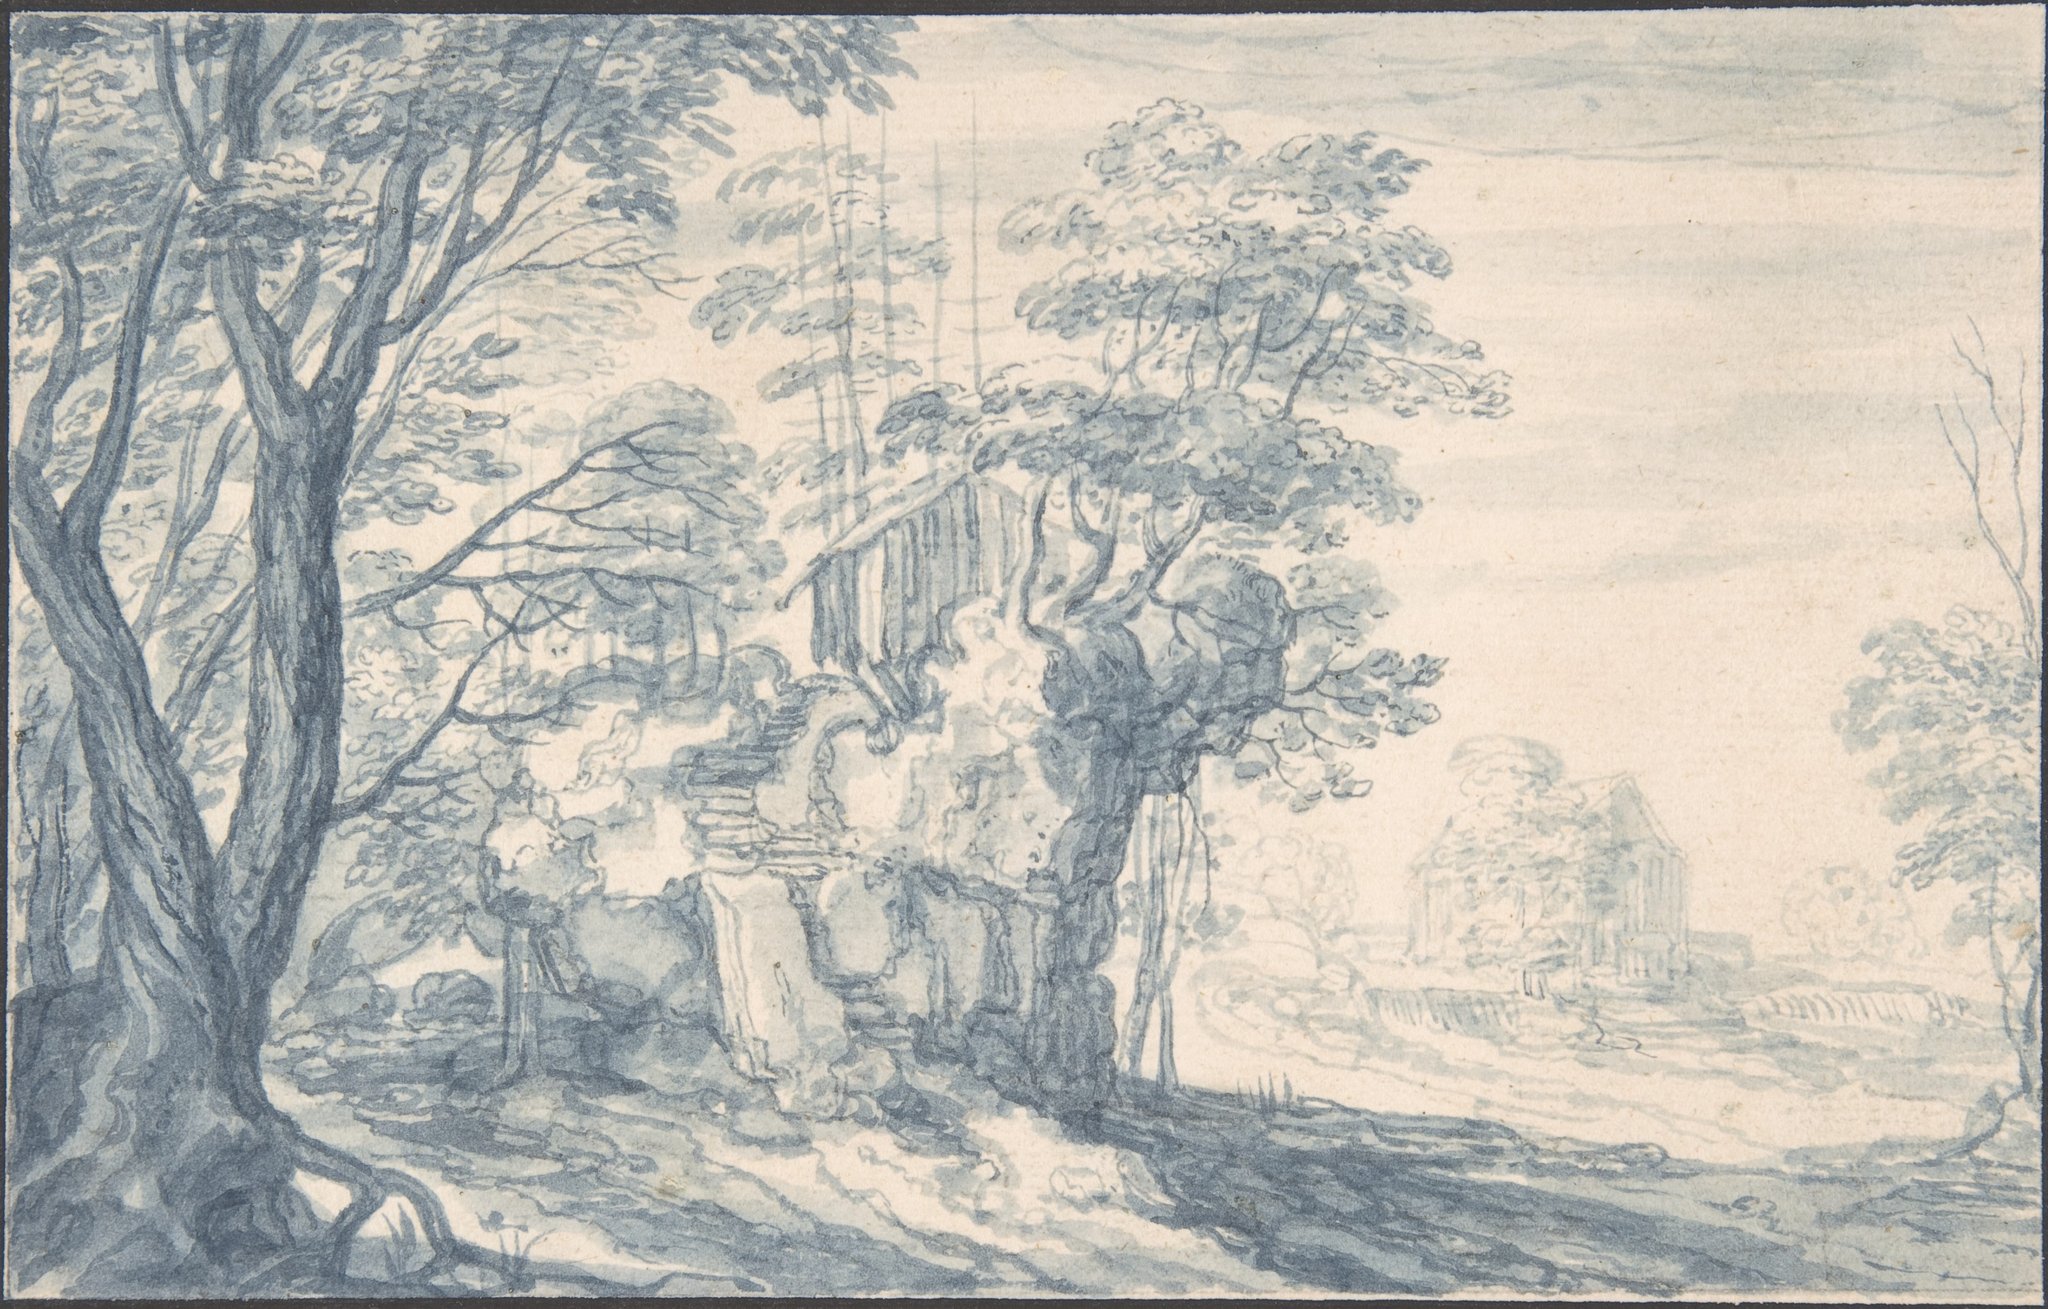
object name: drawing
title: Landscape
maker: isaak major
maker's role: artist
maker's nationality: german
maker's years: 1576-1630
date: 1601-1633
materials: ink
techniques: brush, pen, wash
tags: landscapes,trees